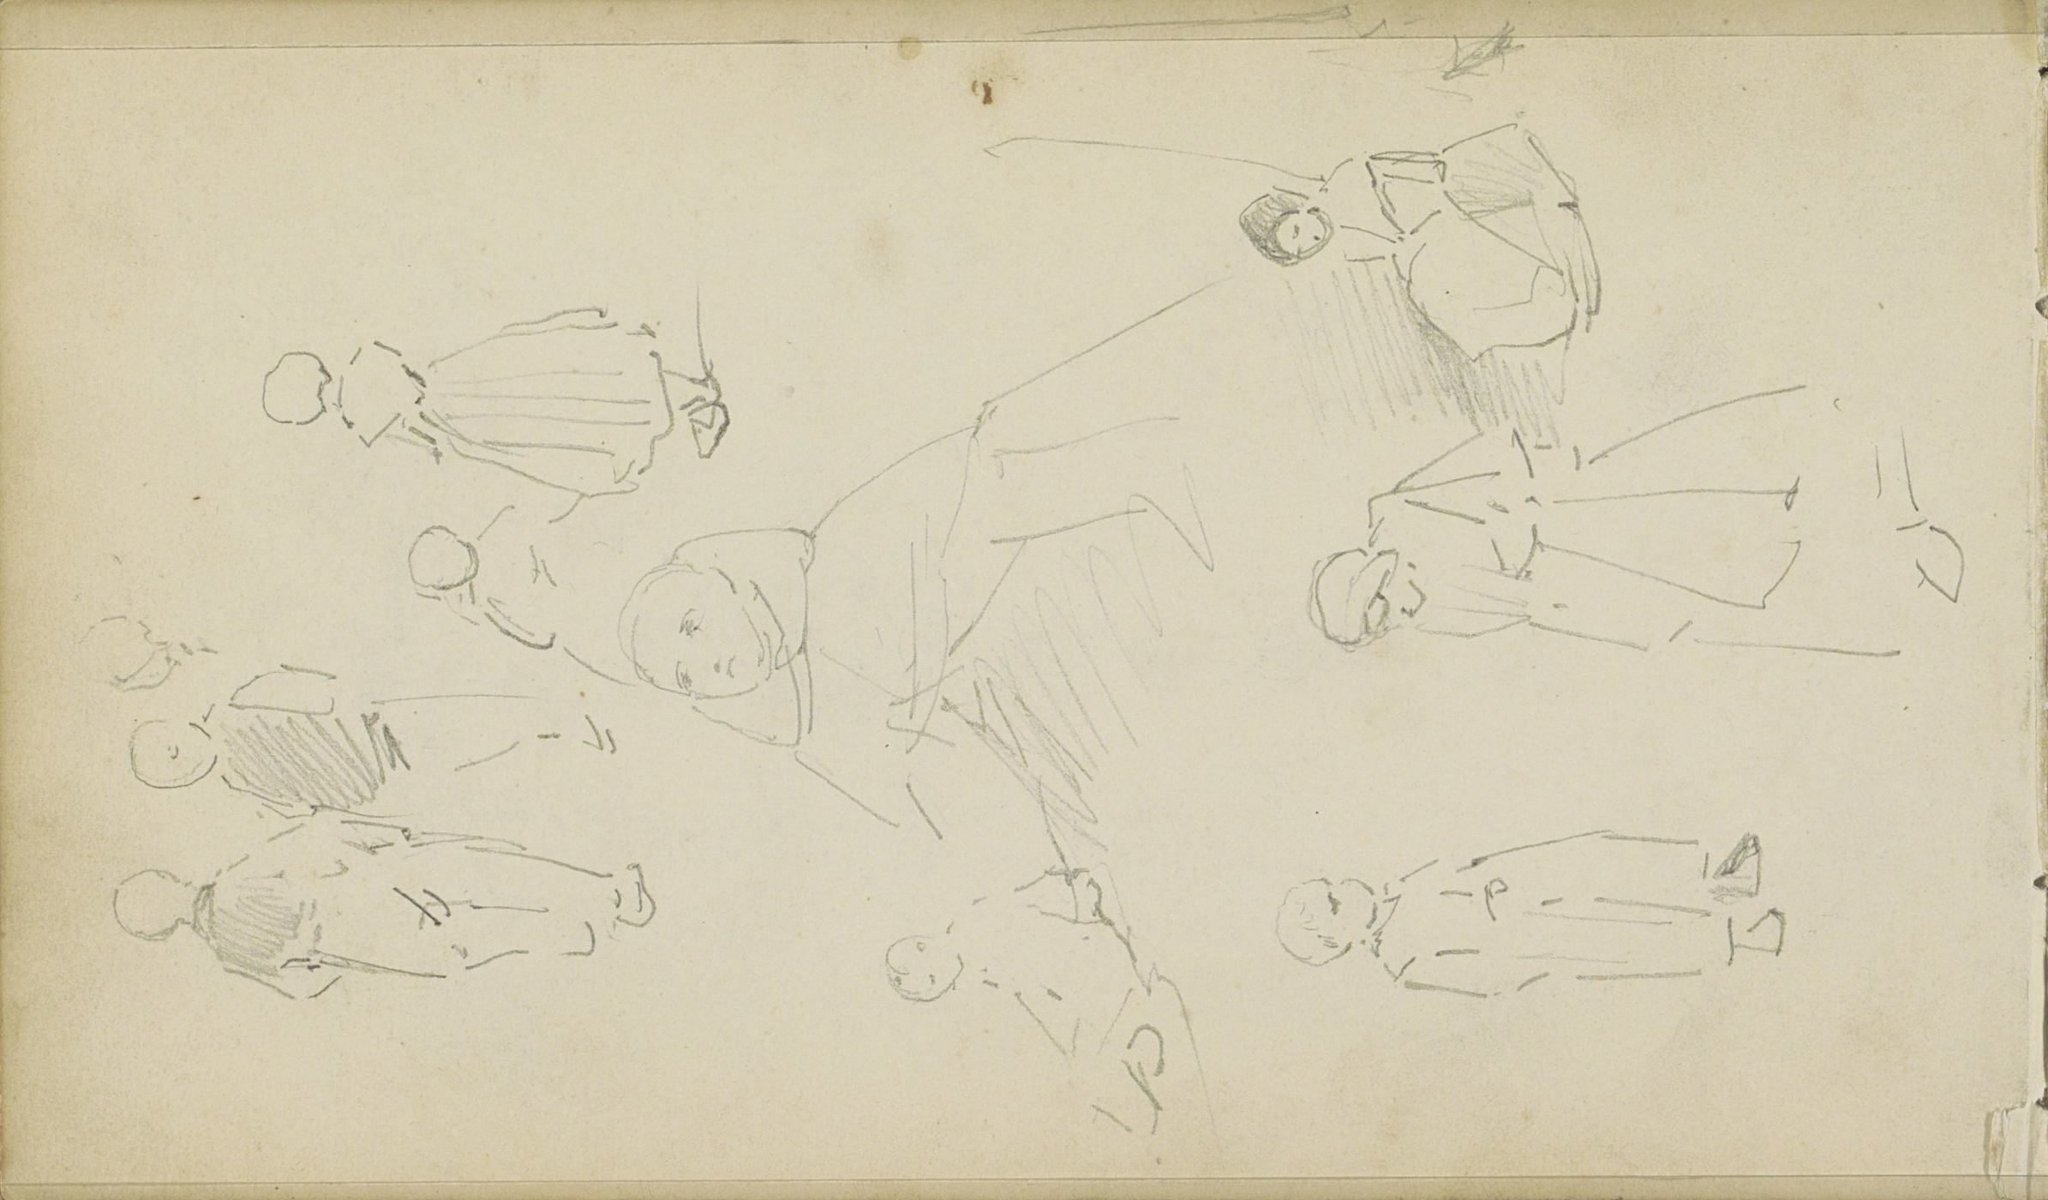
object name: sketchbook leaf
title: Figuurstudies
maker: johannes bosboom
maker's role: draughtsman, painter, print maker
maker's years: 1817-1891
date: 1845-1891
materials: paper, pencil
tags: child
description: Onder andere studies van jongens en meisjes in verschillende houdingen. Blad 7 verso uit een schetsboek met 46 bladen.